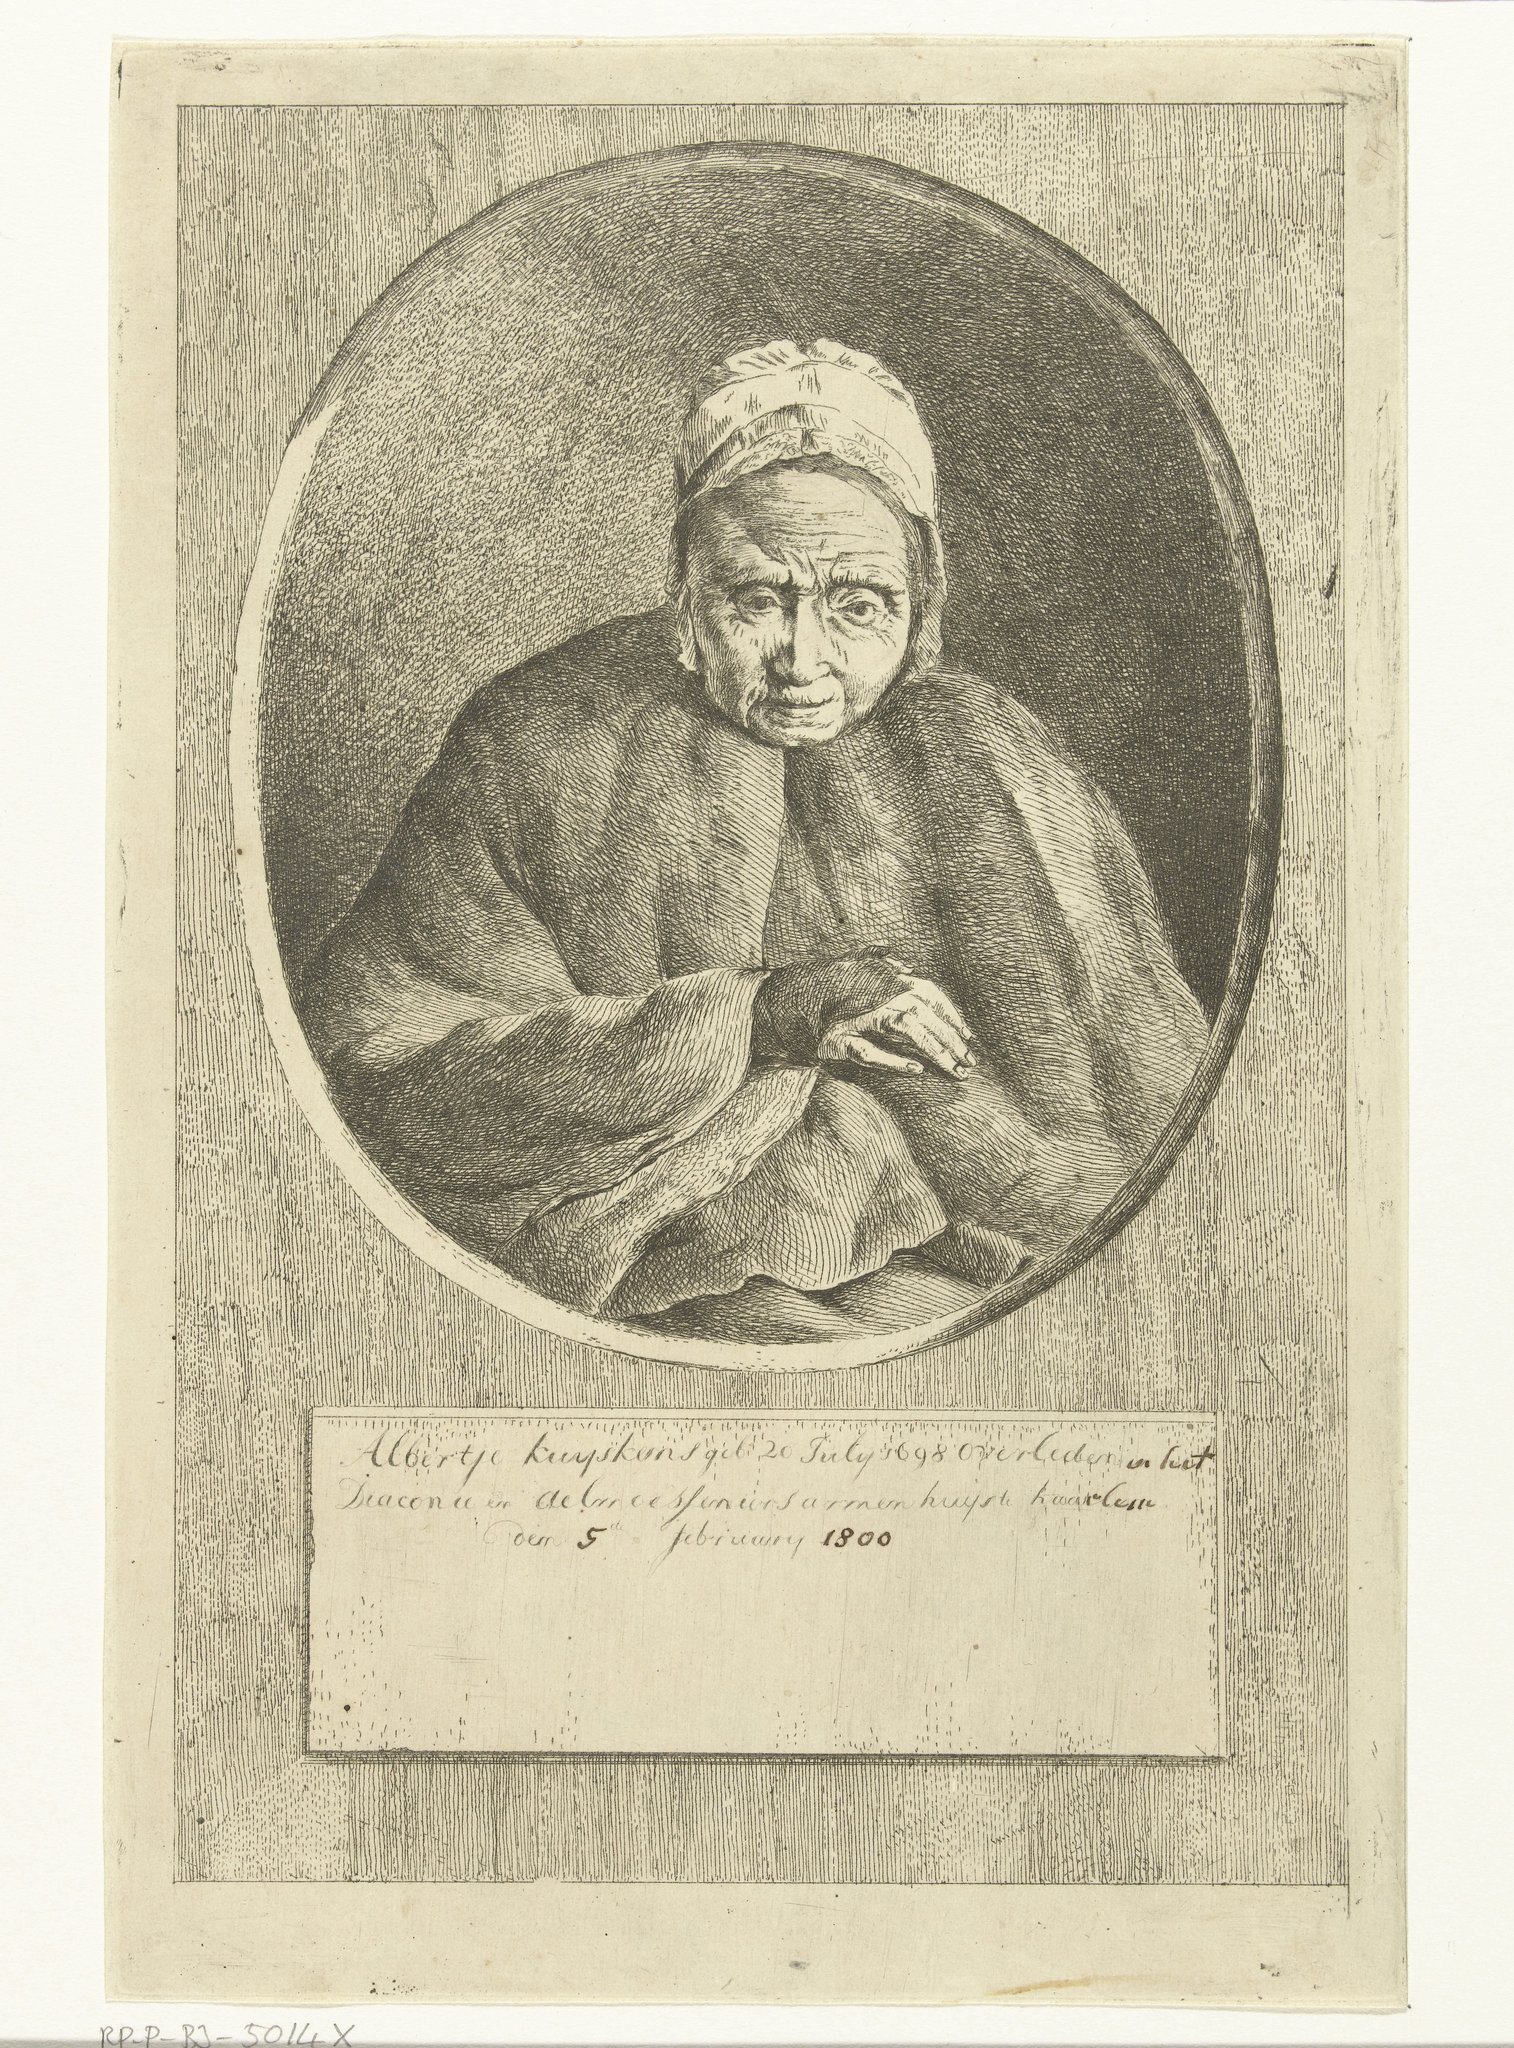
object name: print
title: Portret van Albertje Kuyskens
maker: hermanus van brussel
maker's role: draughtsman, print maker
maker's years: 1763-1815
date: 1800-1802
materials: paper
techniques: etching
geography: netherlands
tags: old woman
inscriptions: collector's mark: Lugt 2228, inscription